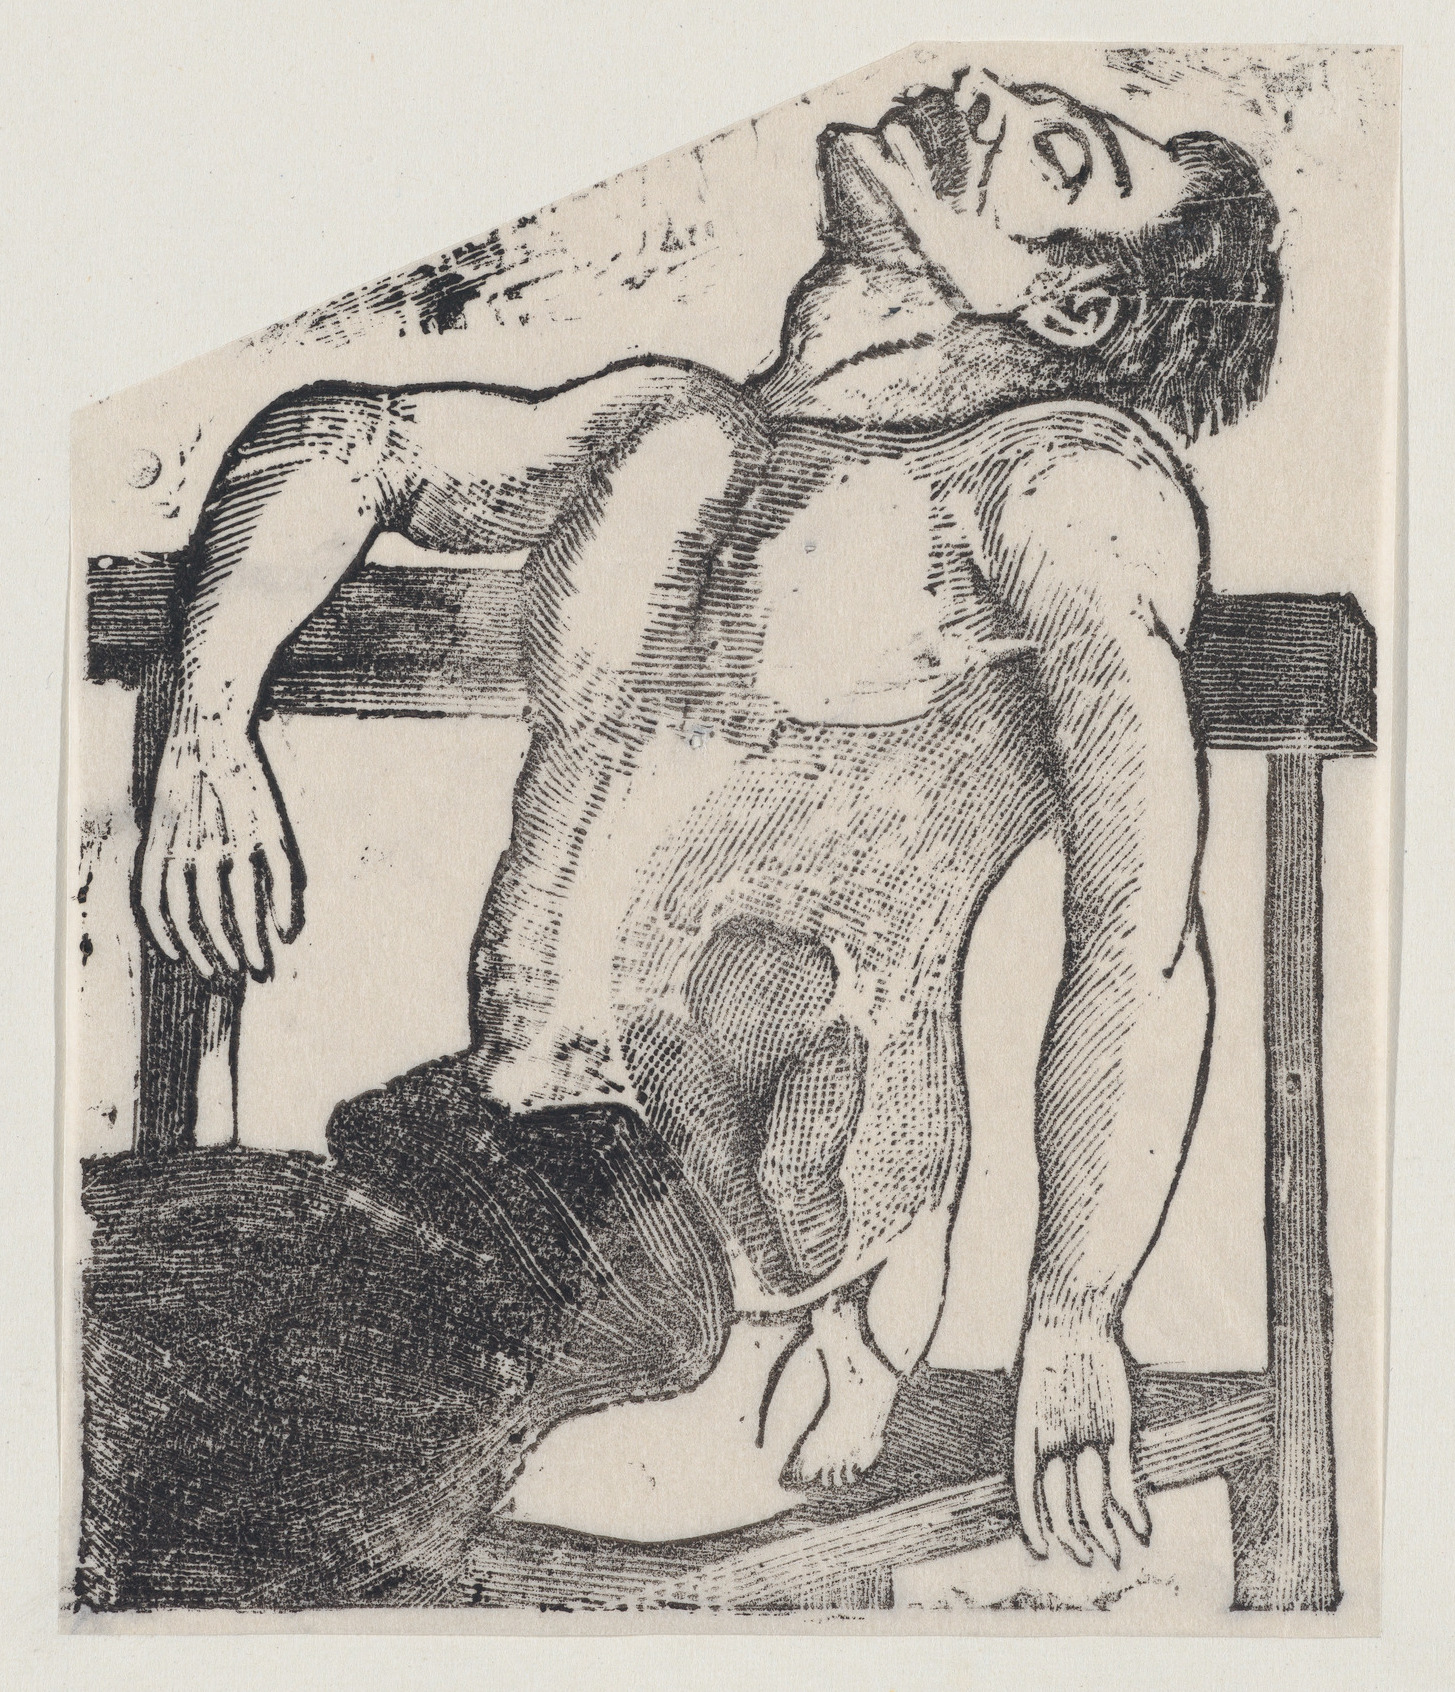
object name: print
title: A man with a small foot emerging from his side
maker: josé guadalupe posada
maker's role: artist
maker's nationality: mexican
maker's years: 1852-1913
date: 1880-1910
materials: metal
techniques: engraving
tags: feet,men